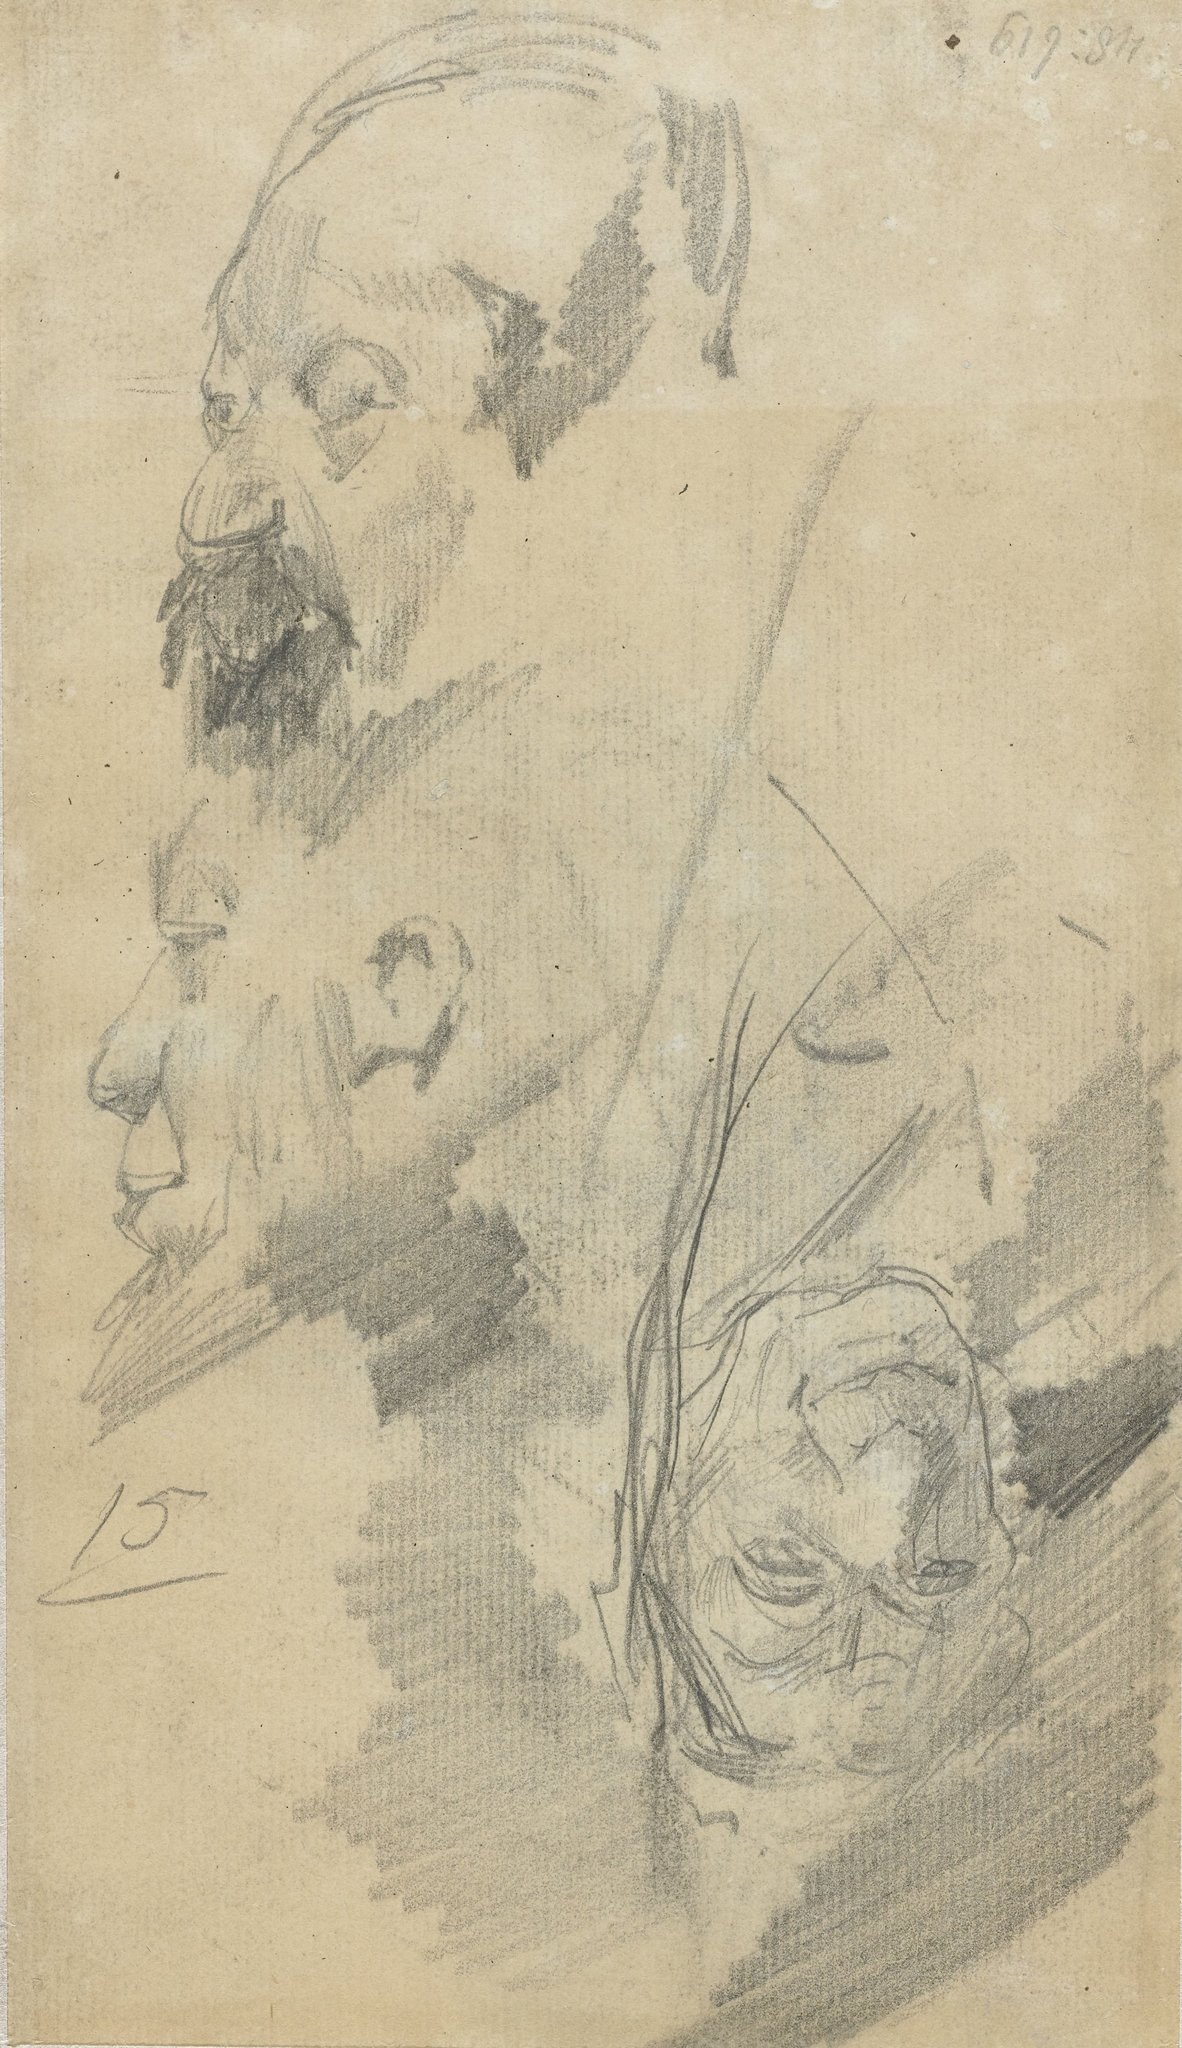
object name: drawing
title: Schetsen van een mannenhoofd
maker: george hendrik breitner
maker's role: draughtsman, painter, print maker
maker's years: 1857-1923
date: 1867-1923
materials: chalk, paper, pencil